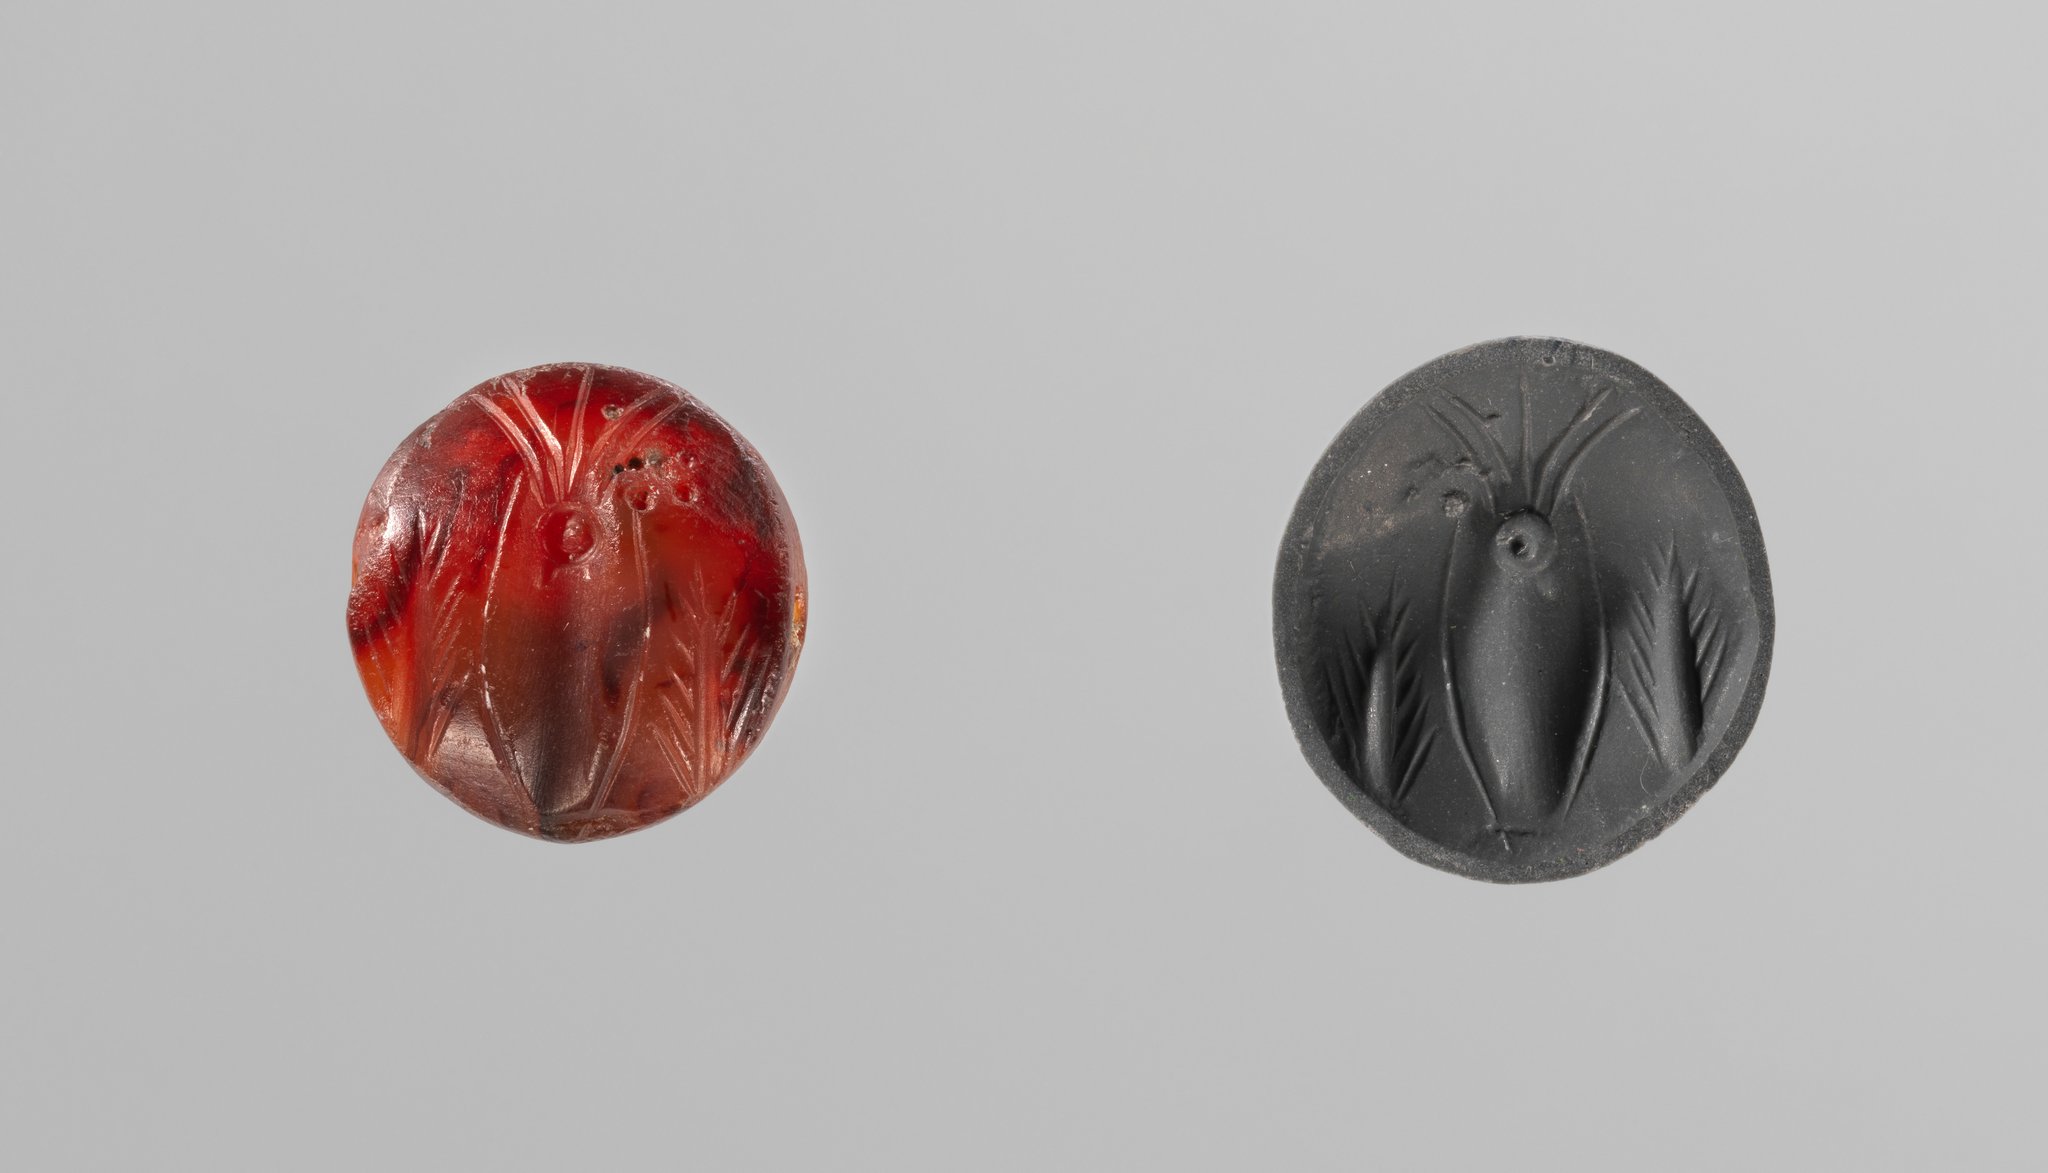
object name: seal, lentoid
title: Carnelian Lentoid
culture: minoan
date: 1650-1500 BCE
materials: gemstone